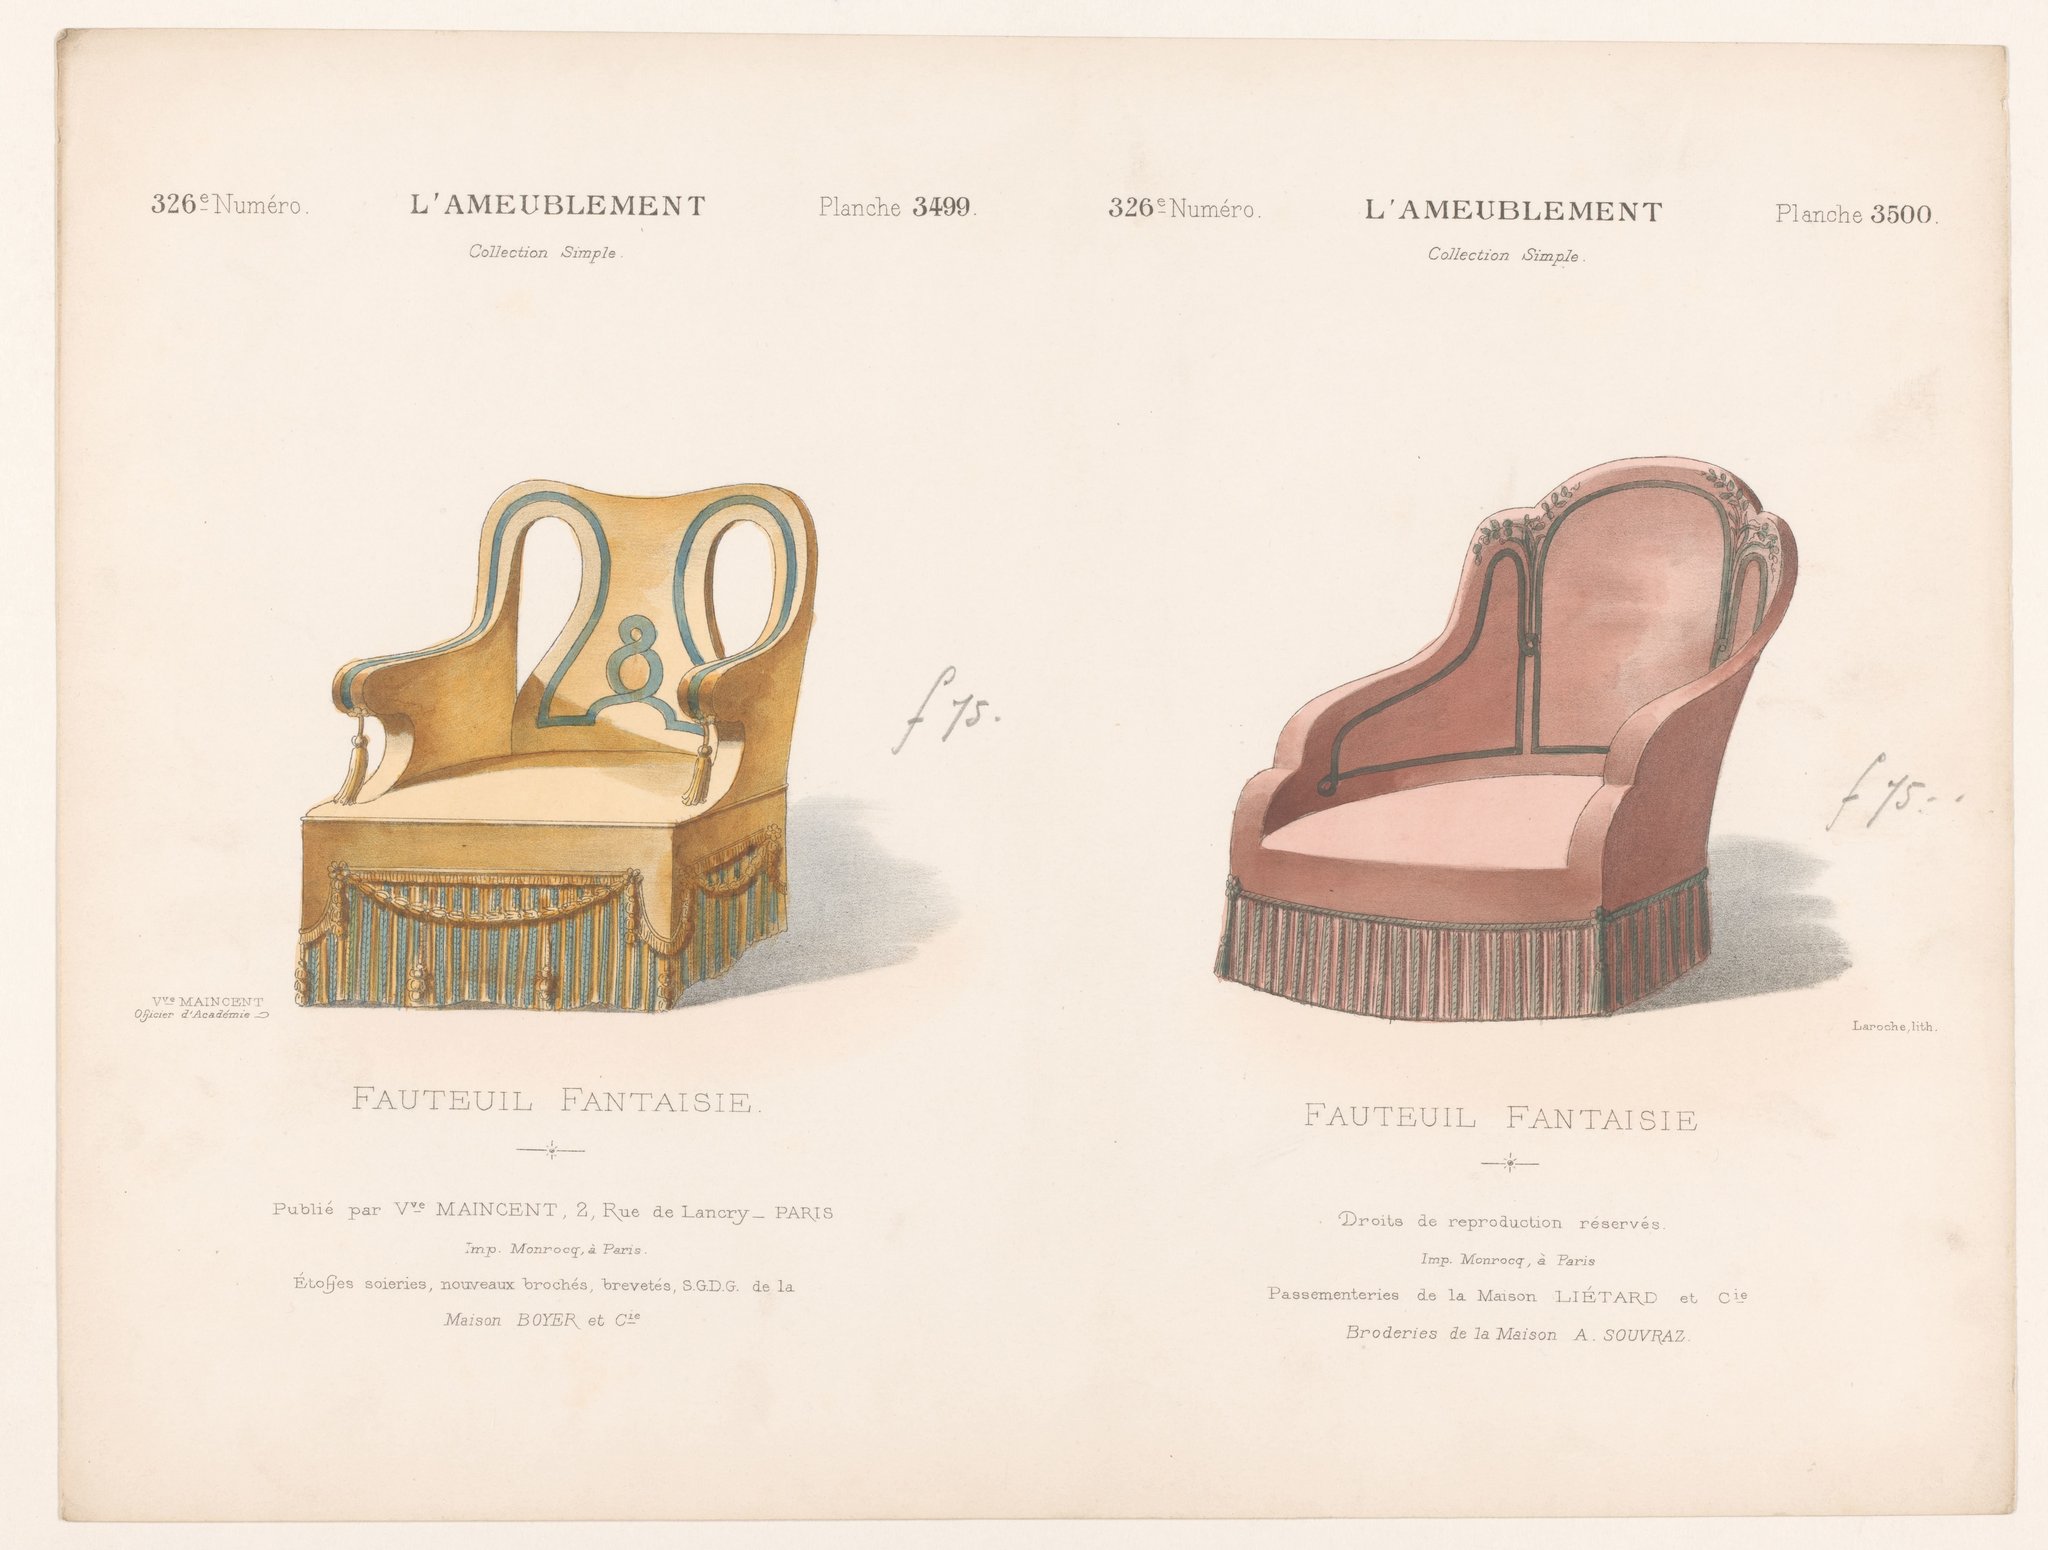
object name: print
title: Twee fauteuils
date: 1895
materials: paper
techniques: hand coloring, lithograph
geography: paris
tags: seating furniture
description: Twee fauteuils. Prent uit 326e nummer (livraison).